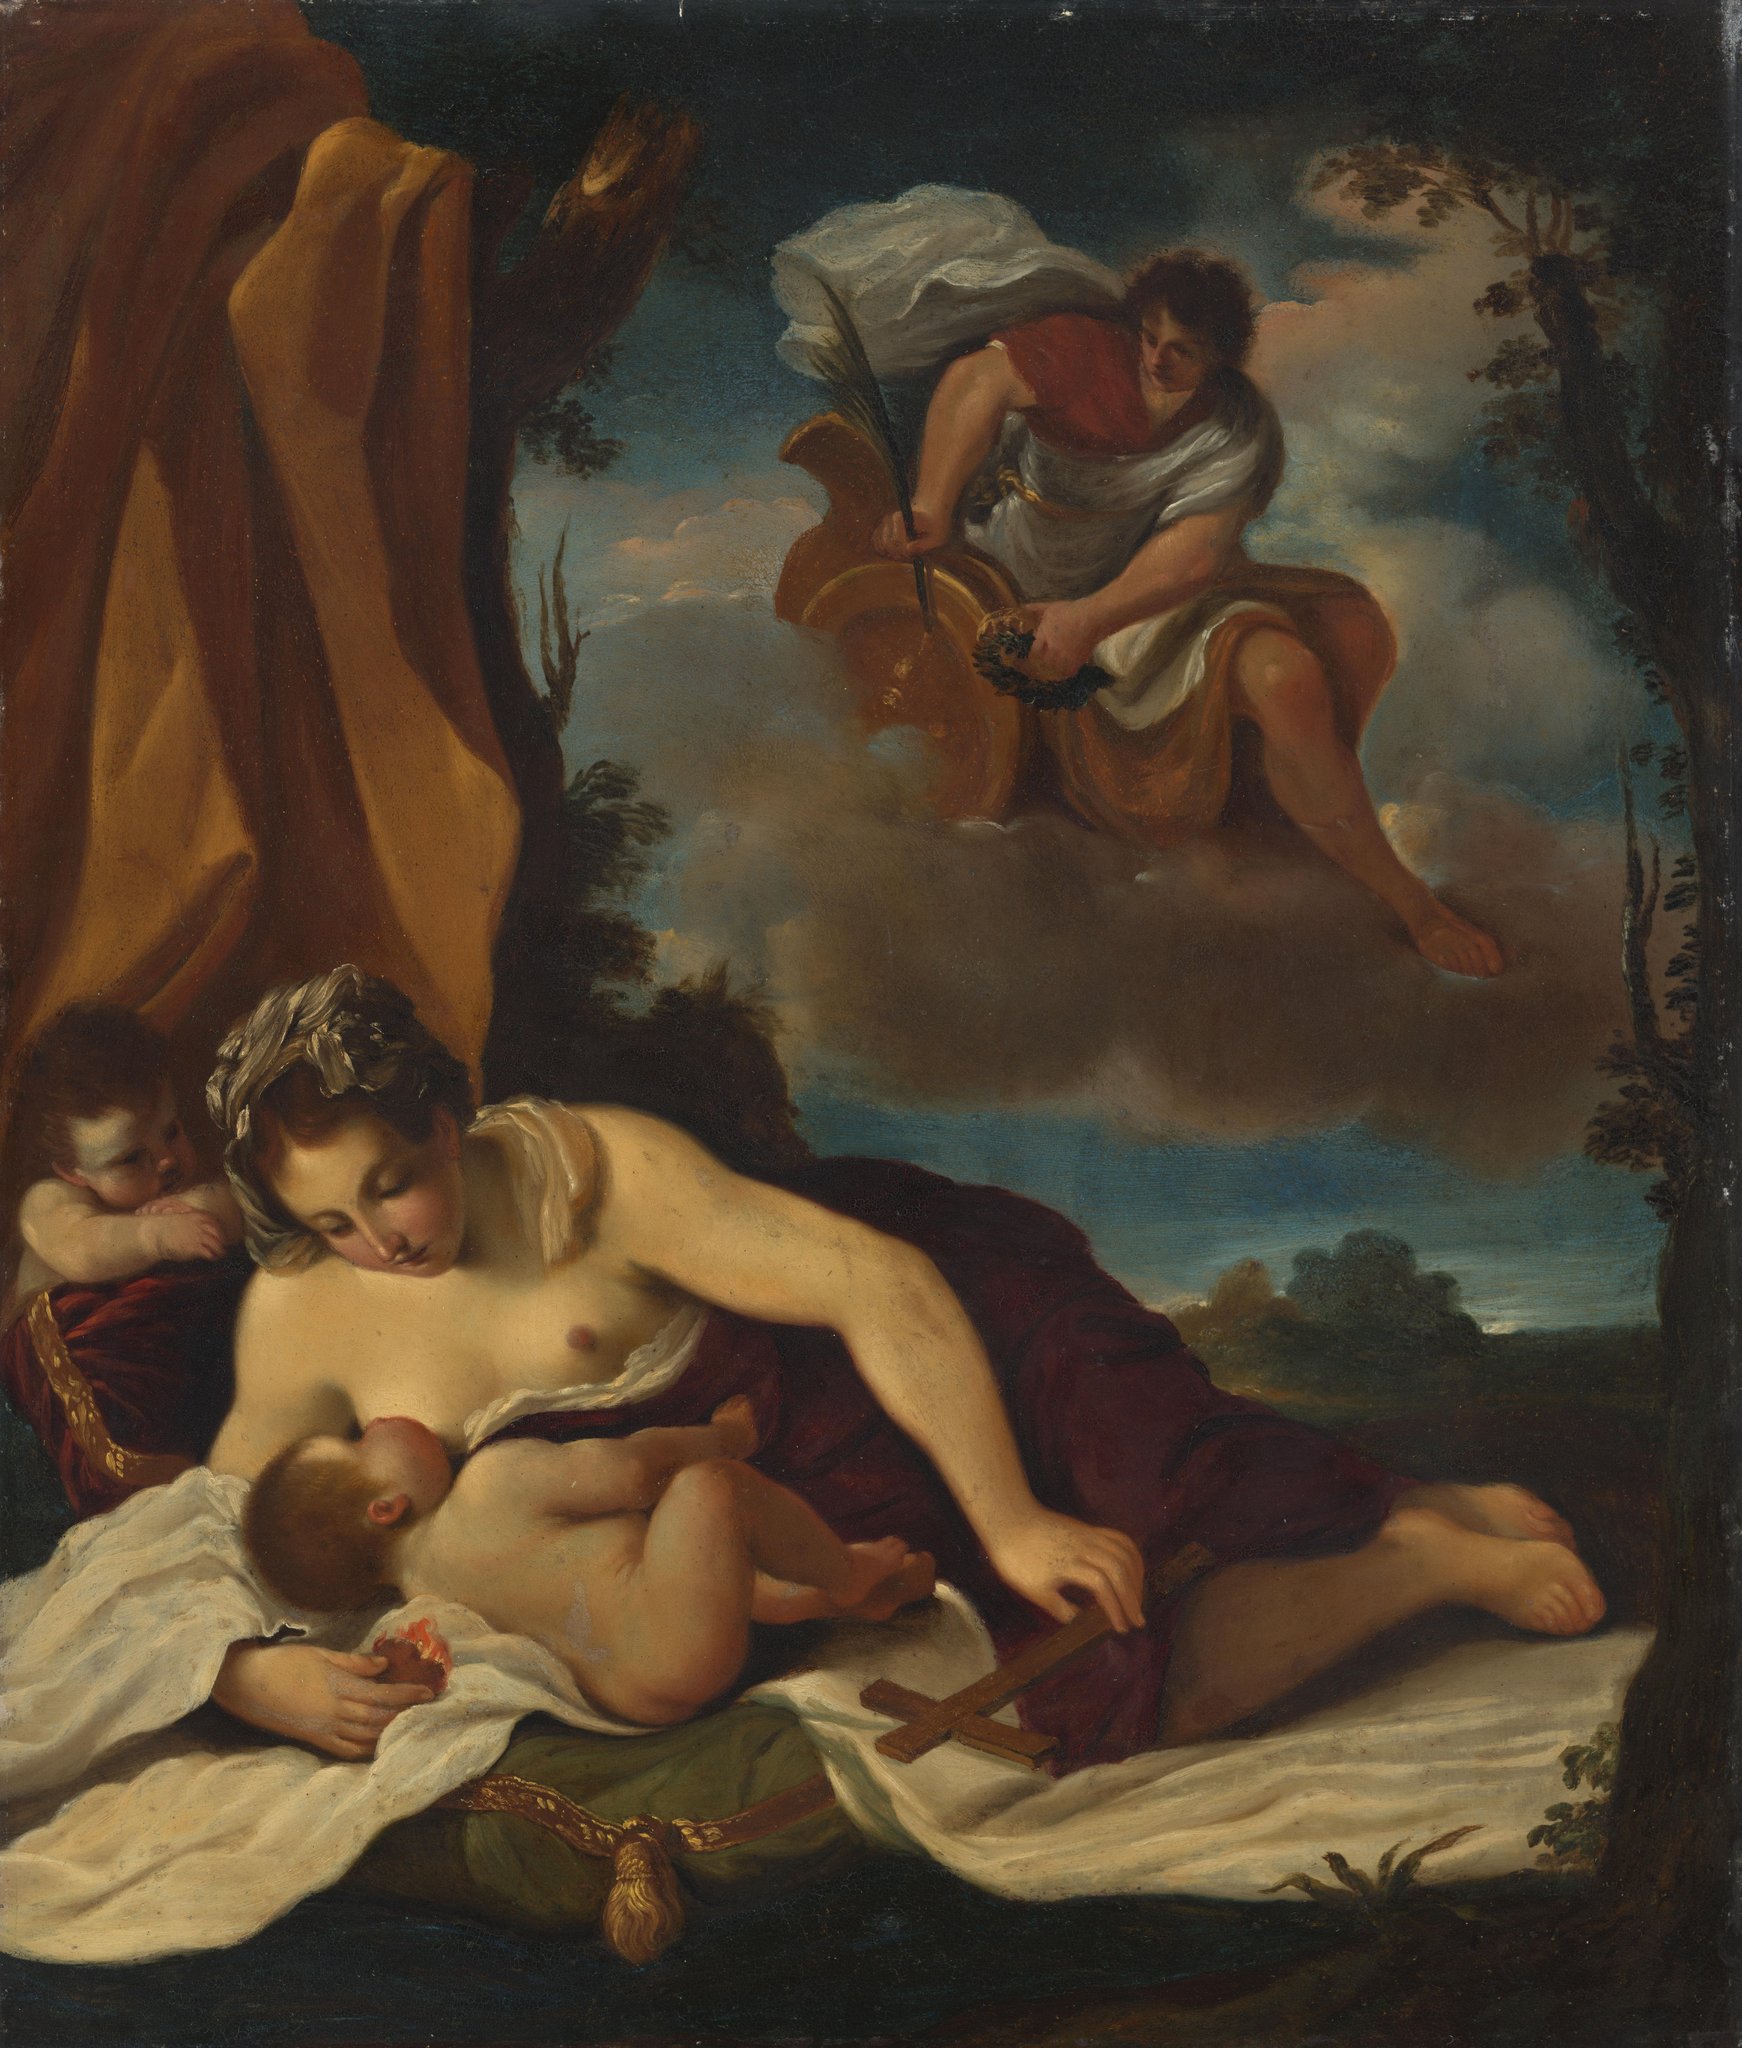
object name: painting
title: Caritas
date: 1610-1716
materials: copper, oil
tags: charity, 'caritas'; 'carità' (ripa) ~ one of the three theological virtues, nursing, suckling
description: In een landschap tussen bomen geeft een vrouw liggend op een doek haar kind de borst, in de linkerhand houdt zij een kruis. Links kijkt een ander kind toe. In de wolken staat een triomfwagen waarin een man die de vrouw een lauwerkrans en een palmtak aanreikt. De voorstelling is geïnterpreteerd als Caritas en als Venus die Amor de borst geeft.